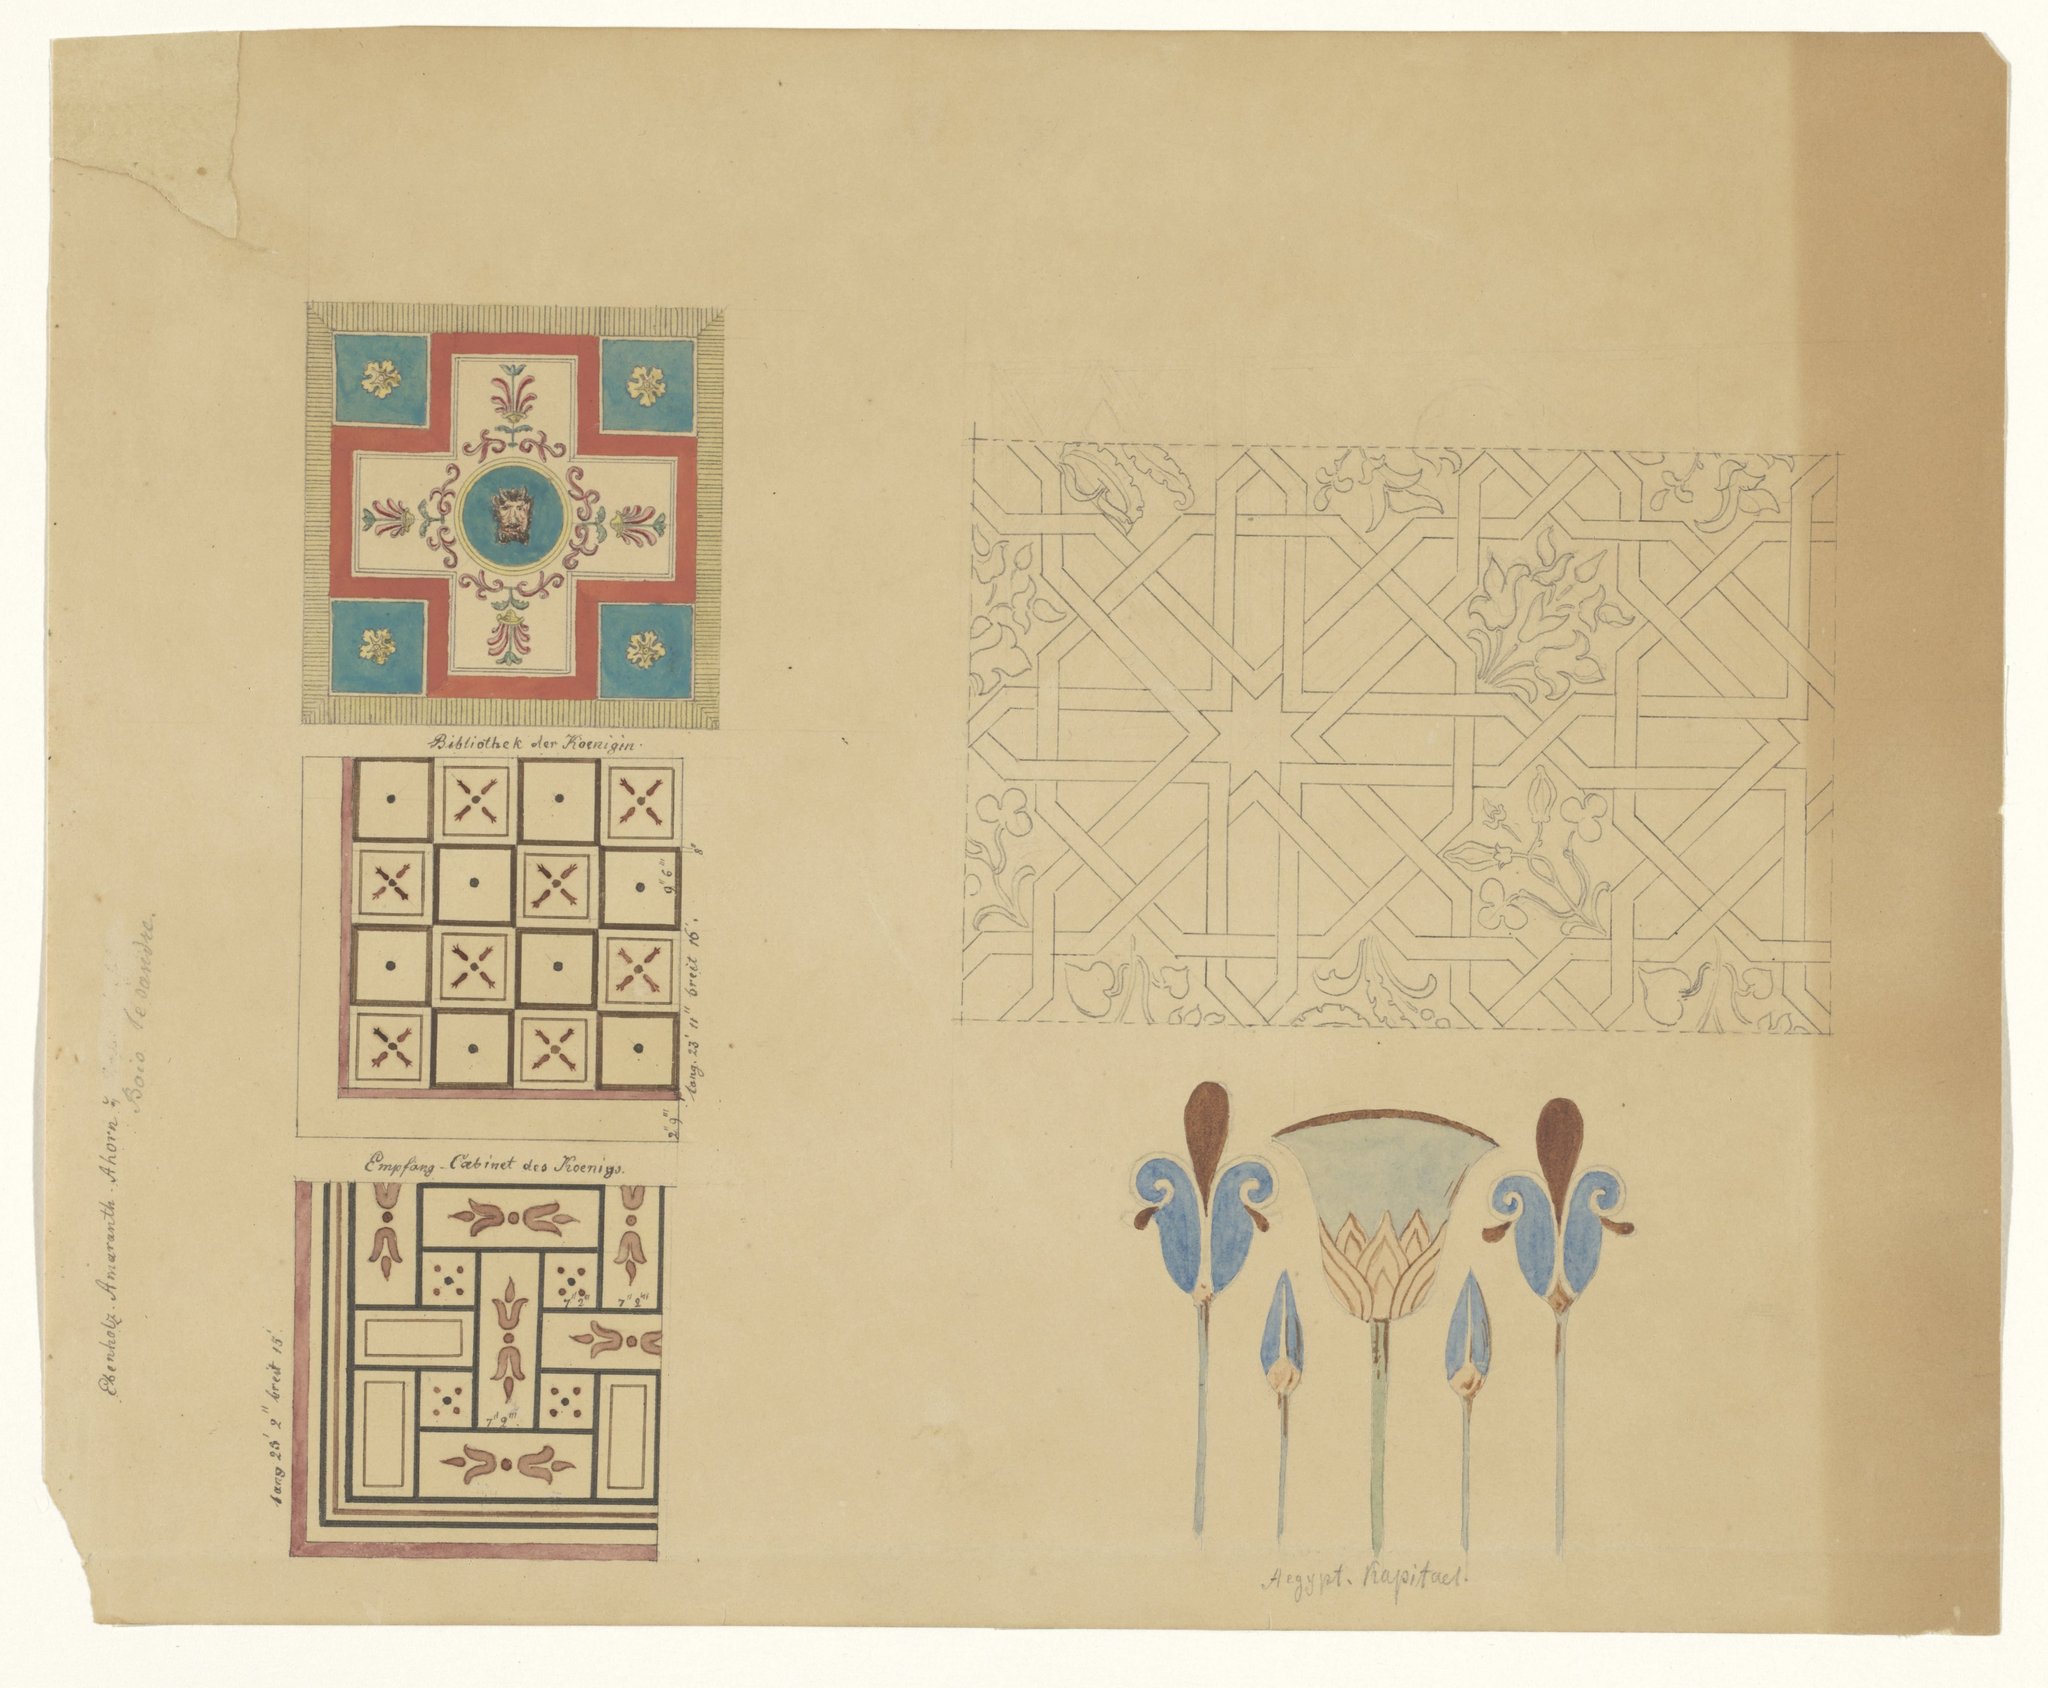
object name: watercolor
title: Tapijt (?), vloeren en Egyptische motieven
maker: franz jakob kreuter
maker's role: architect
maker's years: 1813-1889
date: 1835-1860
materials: paper, pencil, watercolor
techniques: brush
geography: vienna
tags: ornaments ~ art, floor-covering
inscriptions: inscription: ‘Ebenholz.Amaranth.Ahorn. [uitgevlakte woorden, daaronder:] Bois lesandre / Bibliothek der Koenigin / Empfang-Cabinet des Koenigs / 2’’9’’’ lang. 23’11’’breit 16’. 9’’16’’’ / lang 23’2’’ breit 15’ / Aegypt. Kapitael.’